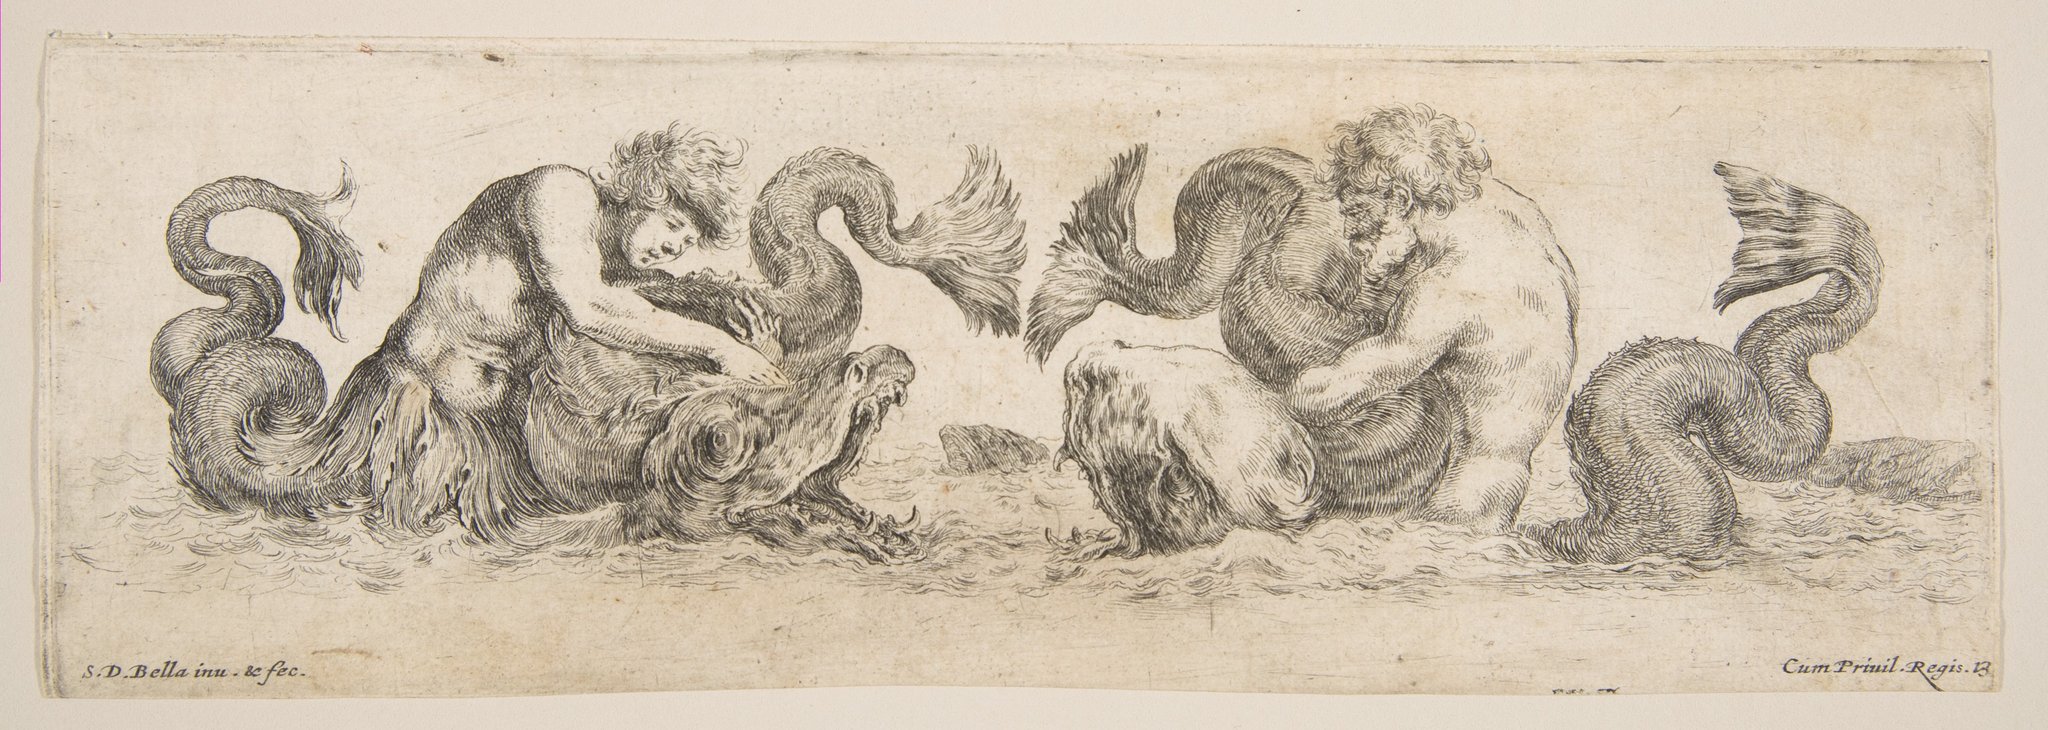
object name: print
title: Frieze with Tritons and Dolphins, plate 13 from "Decorative friezes and foliage" (Ornamenti di fregi e fogliami)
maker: stefano della bella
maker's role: artist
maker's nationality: italian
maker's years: 1610-1664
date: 1648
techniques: etching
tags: triton,dolphins